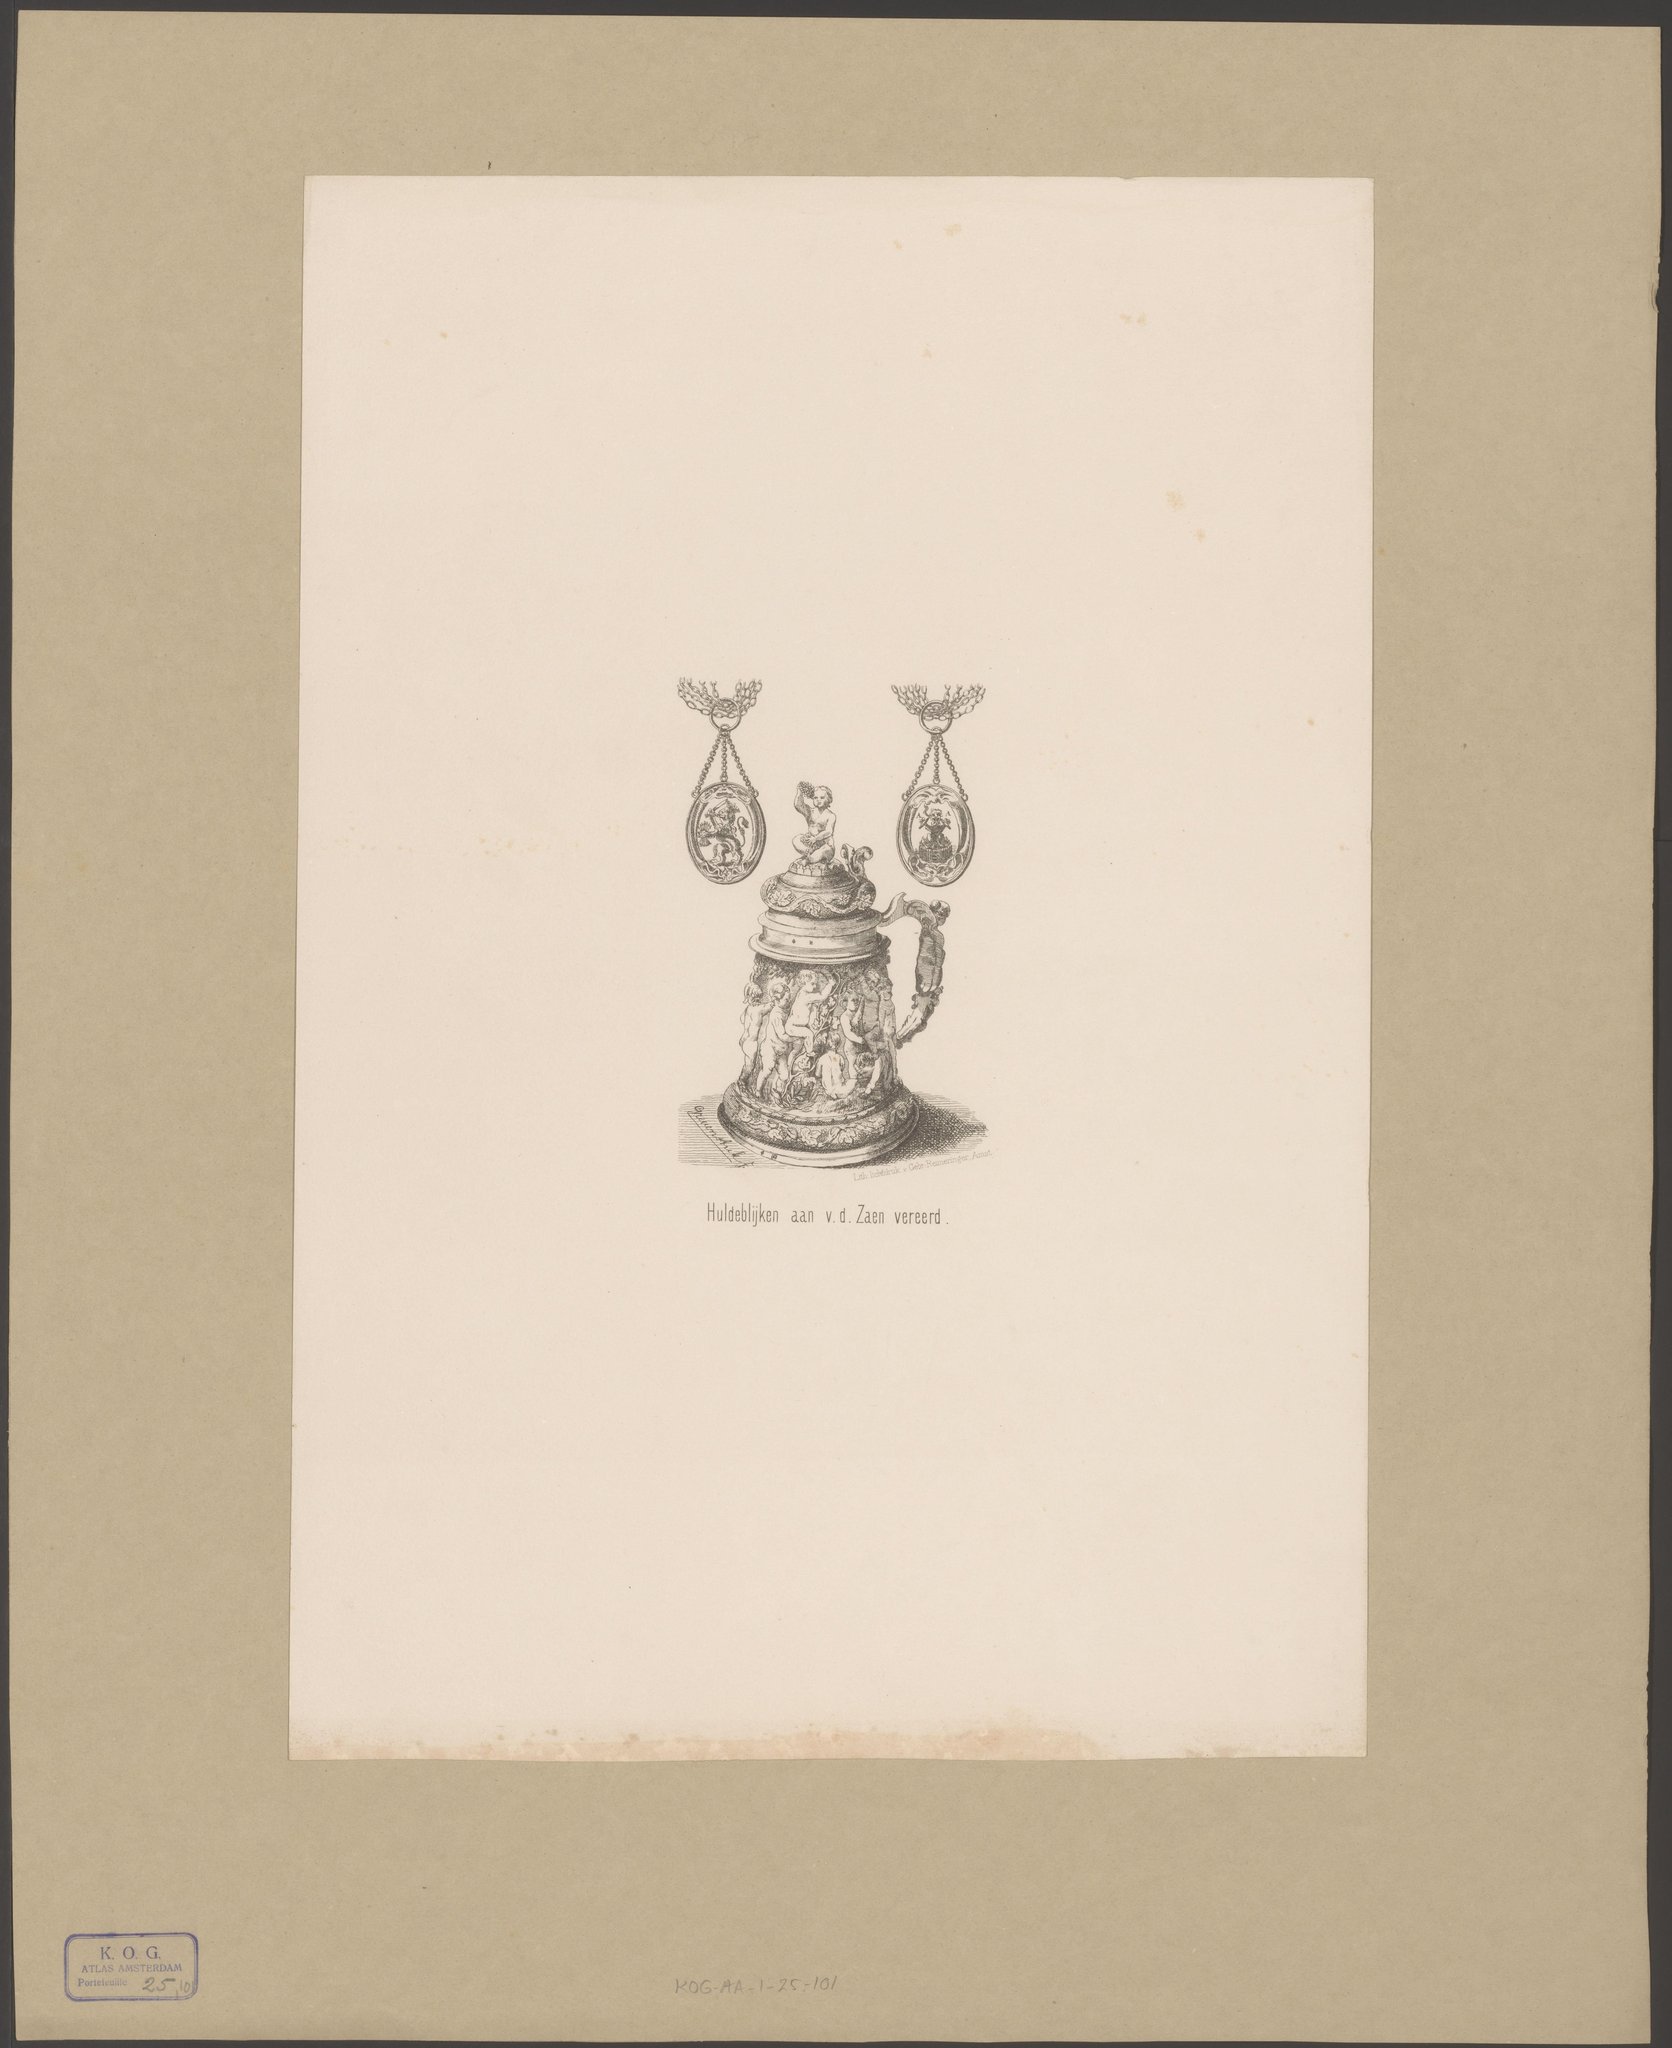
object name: photomechanical print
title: Huldeblijken aan v. d. Zaen vereerd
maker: Anonymous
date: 1872-1915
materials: paper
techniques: photolithography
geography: amsterdam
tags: coat of arms (as symbol of the state, etc.), tankard, anthropomorphic ornament, foliage ~ ornament, device (as symbol of the state, etc.)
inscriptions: collector's mark: ‘25.101’ Lugt 1641b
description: Een ornamentele bierpul met erboven twee medaillons met de Generaliteitsleeuw en het wapen van de Admiraliteit van Amsterdam. Onderwerpsrubriek binnen de Atlas Amsterdam: Krijgswezen I: De Admiraliteit van Amsterdam, B. Vlootvoogden en schepelingen; Herinneringen daaraan.